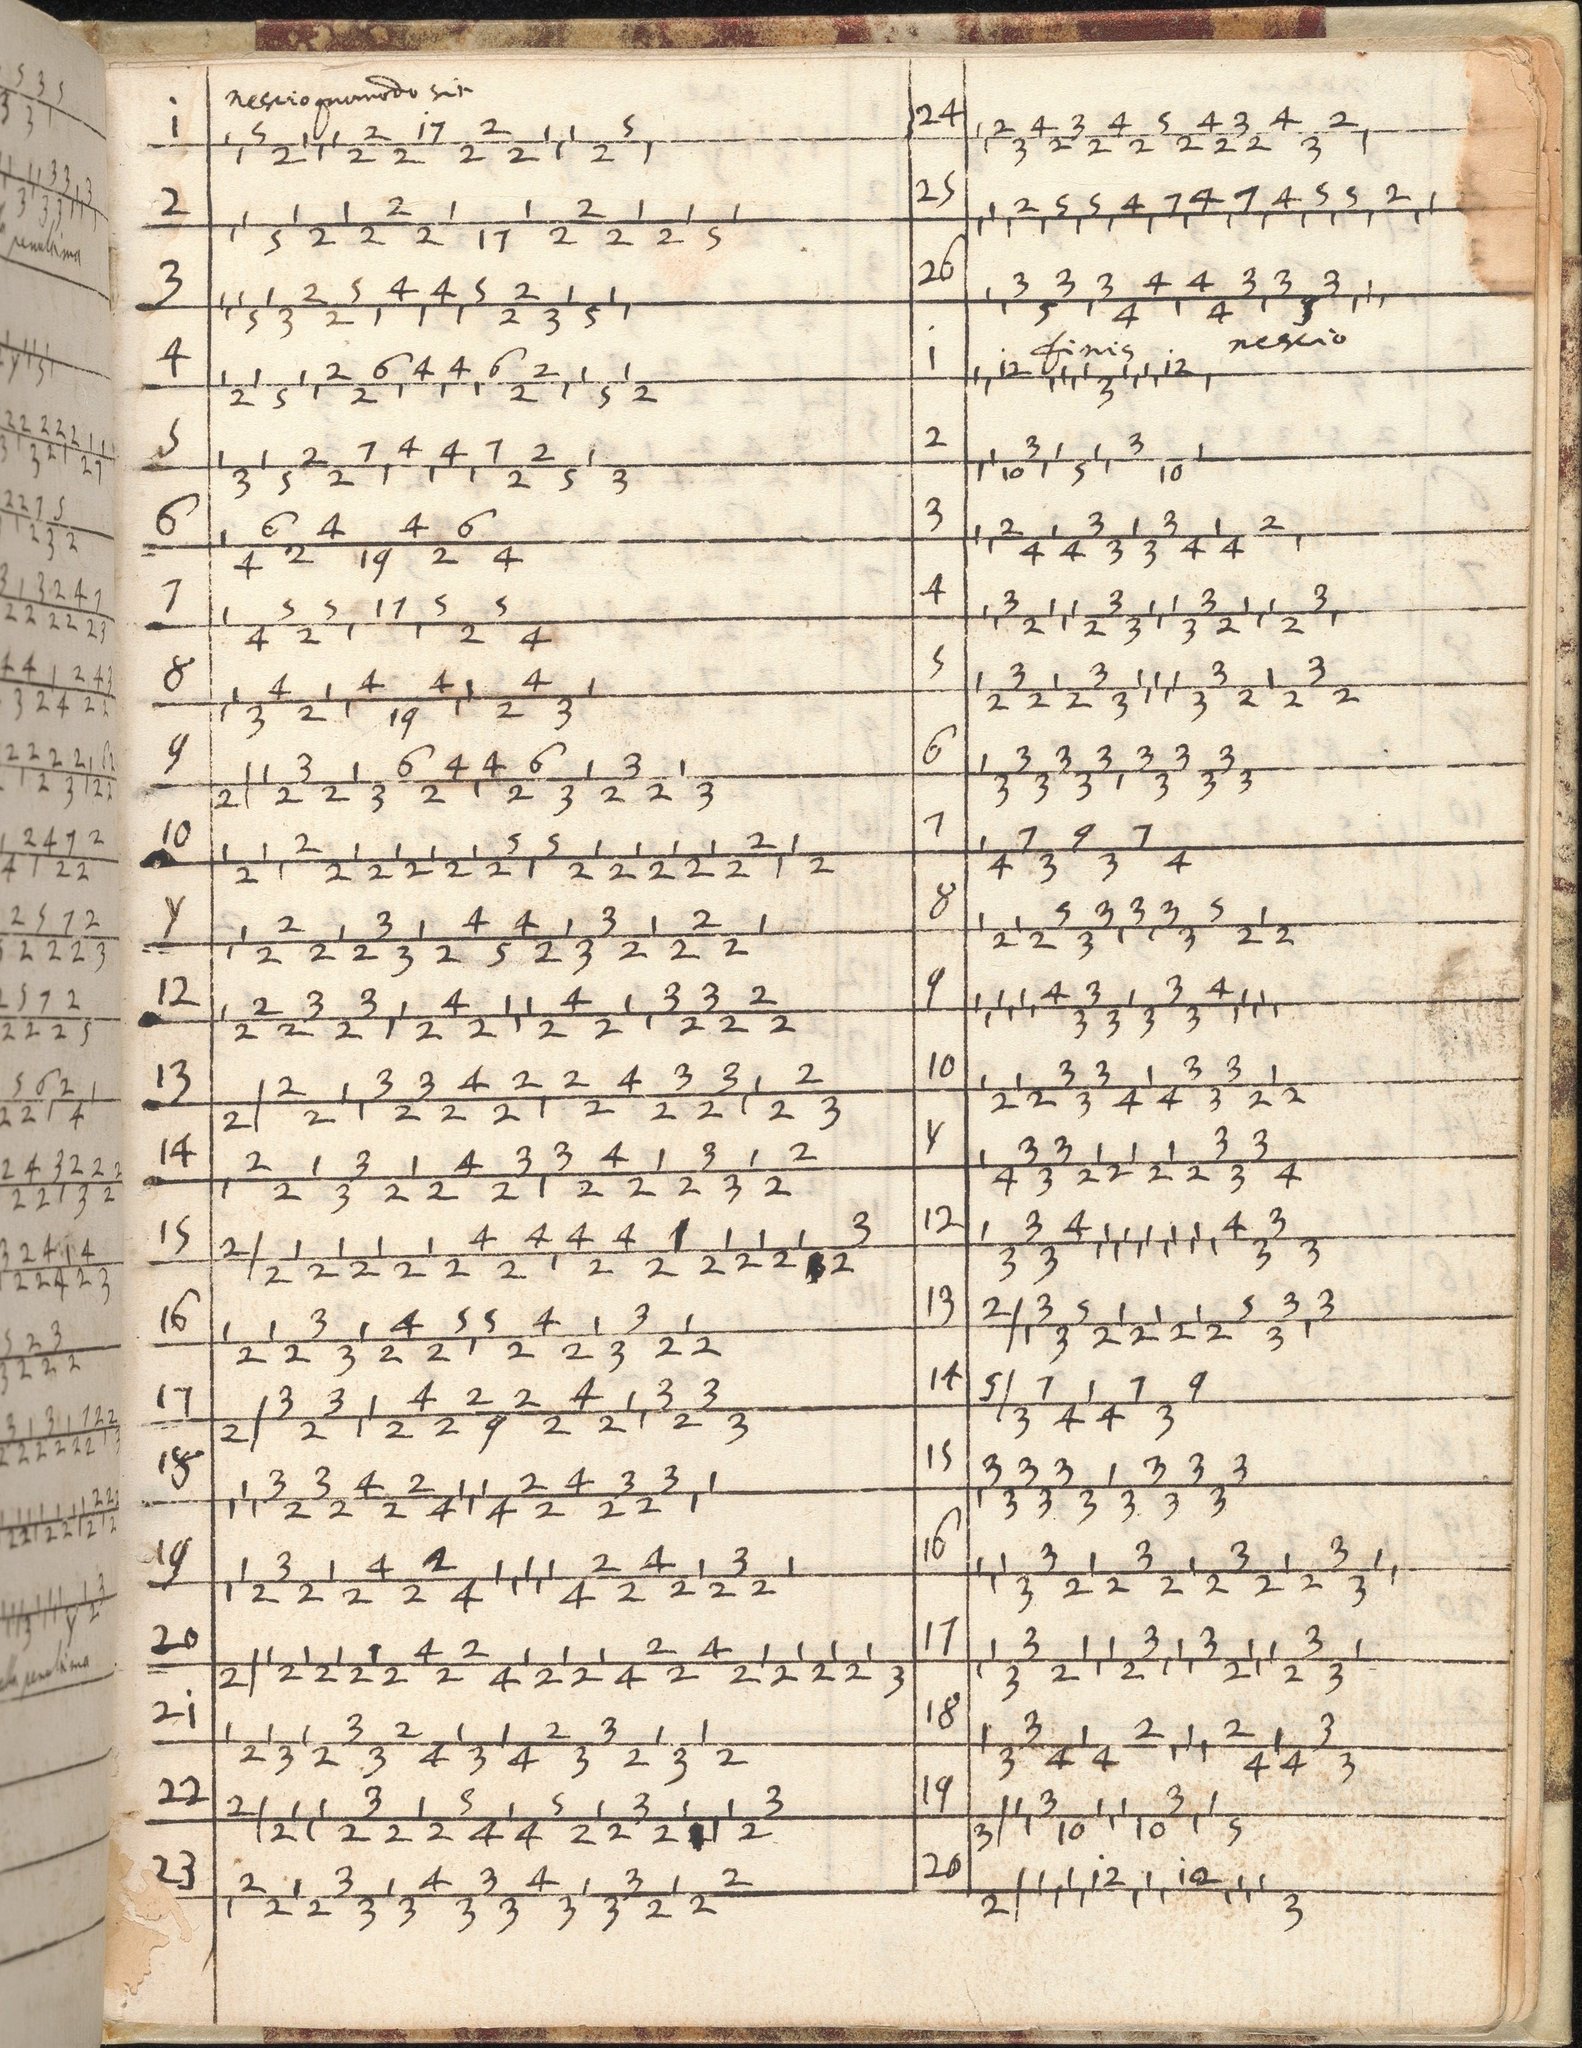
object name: book print ornament architecture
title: Ein new getruckt model Büchli...Page 25, verso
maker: johann schönsperger the younger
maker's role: publisher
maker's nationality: german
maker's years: 1490-1550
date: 1529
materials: ink, paper